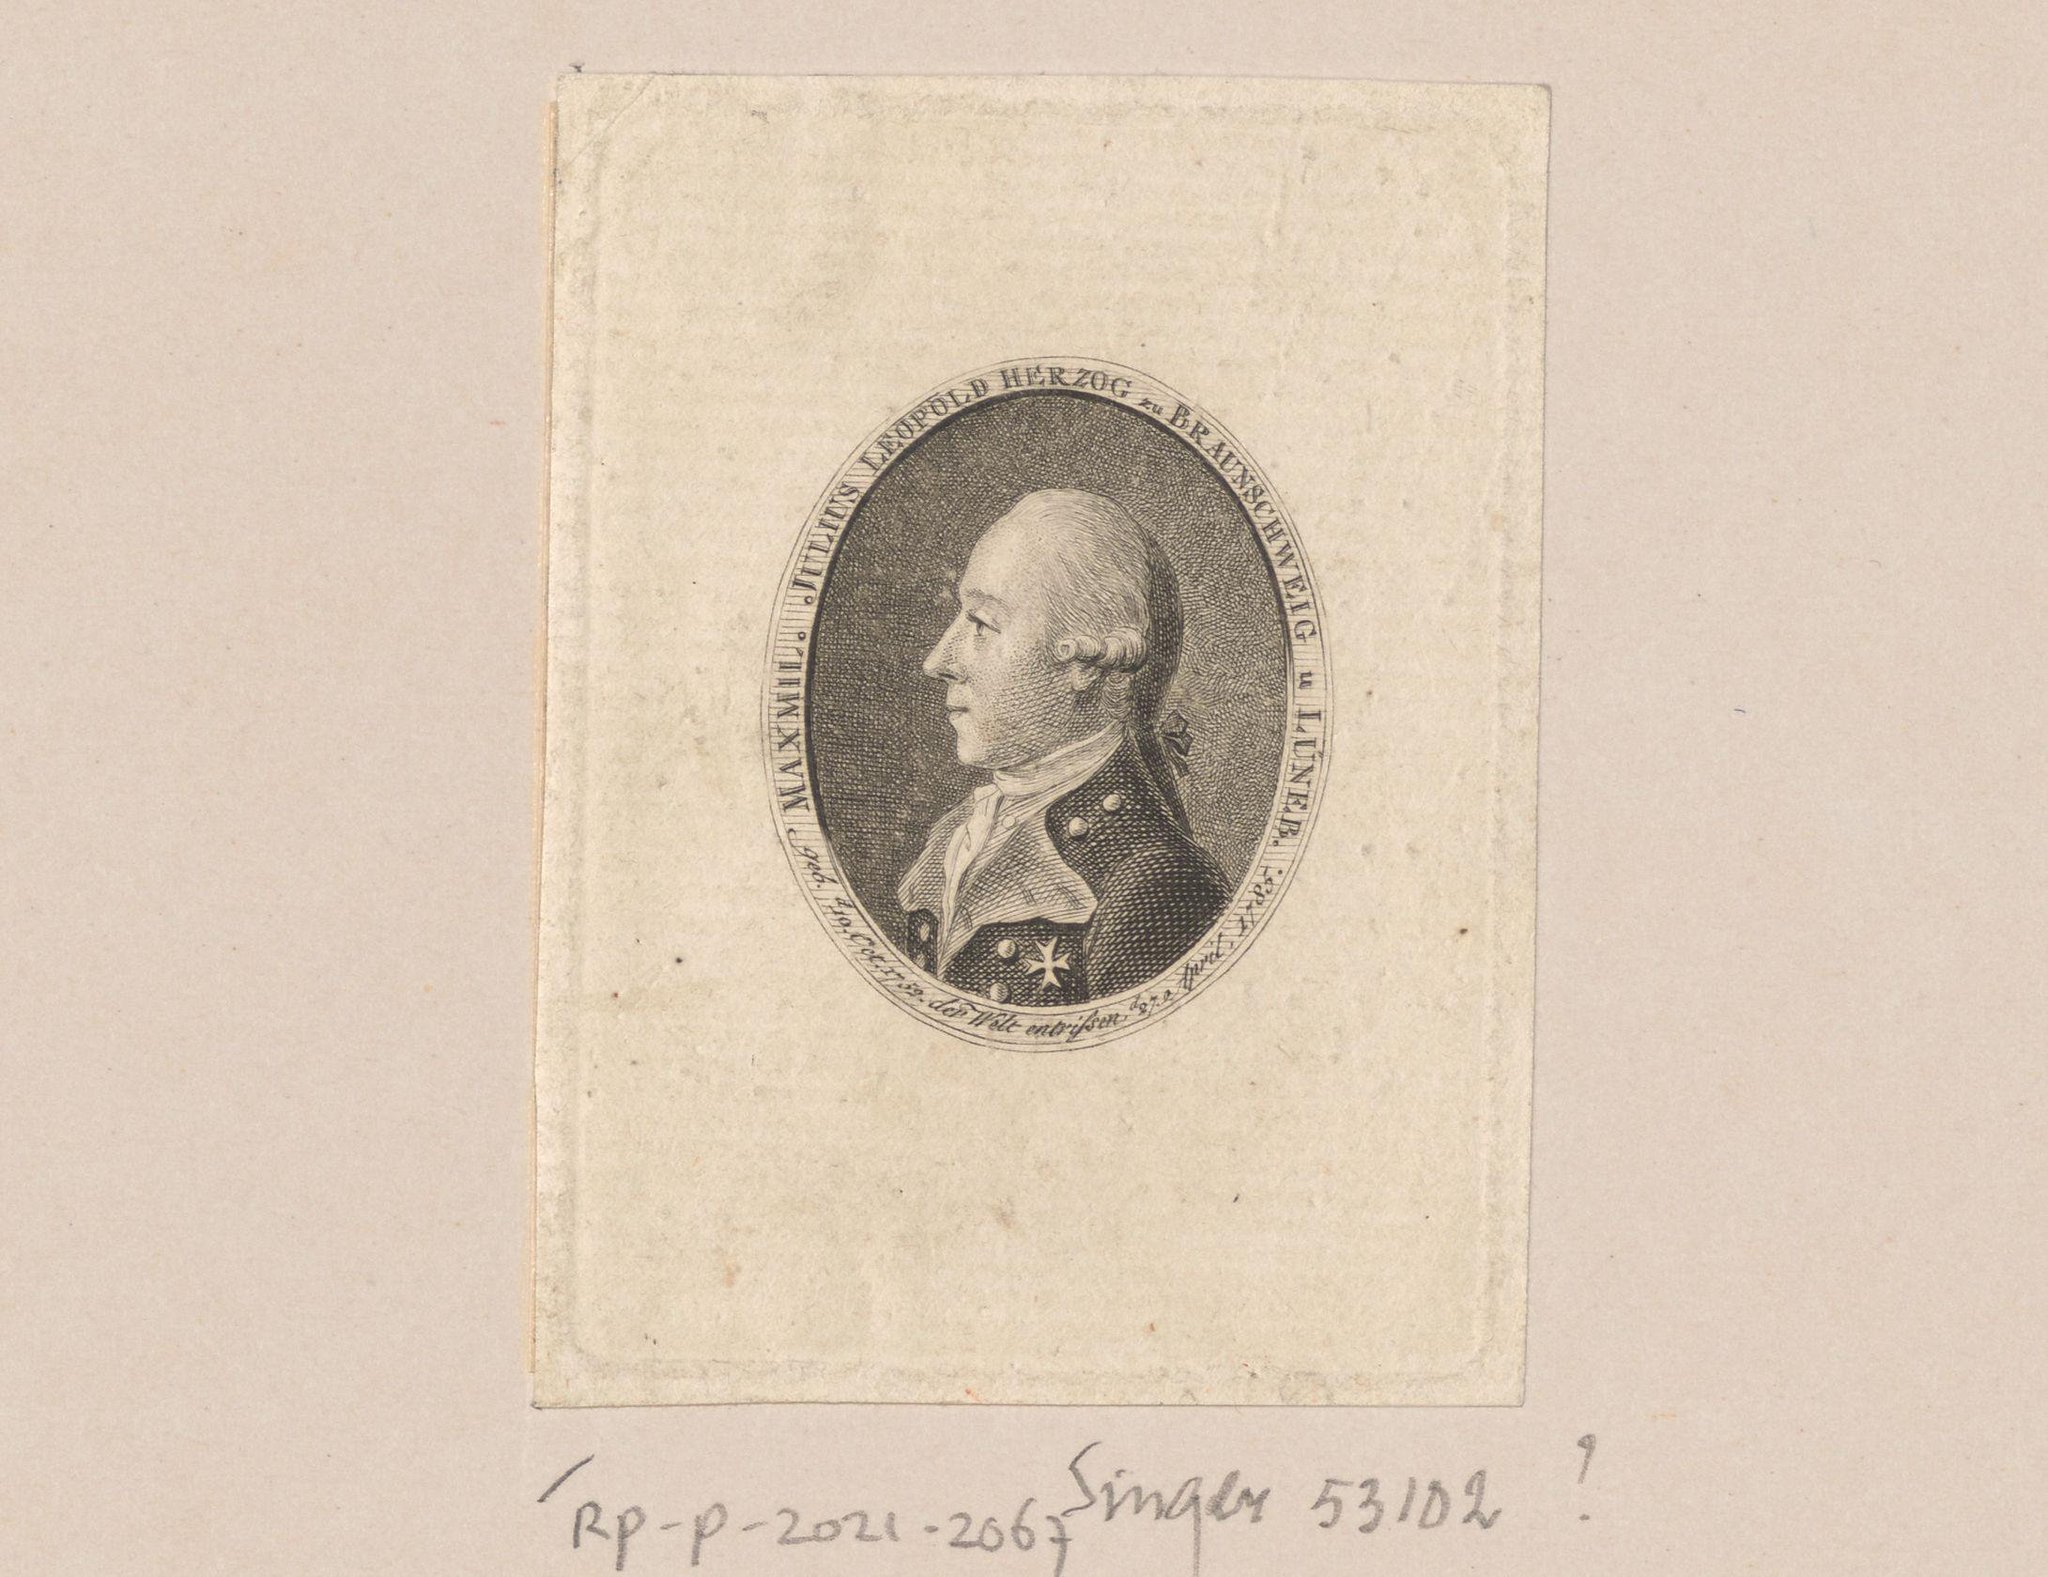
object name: print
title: Portret van Maximilian Julius Leopold van Brunswijk-Wolfenbüttel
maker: Anonymous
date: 1785-1799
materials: paper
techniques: engraving, etching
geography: germany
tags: ornament ~ medallion, historical persons, wig